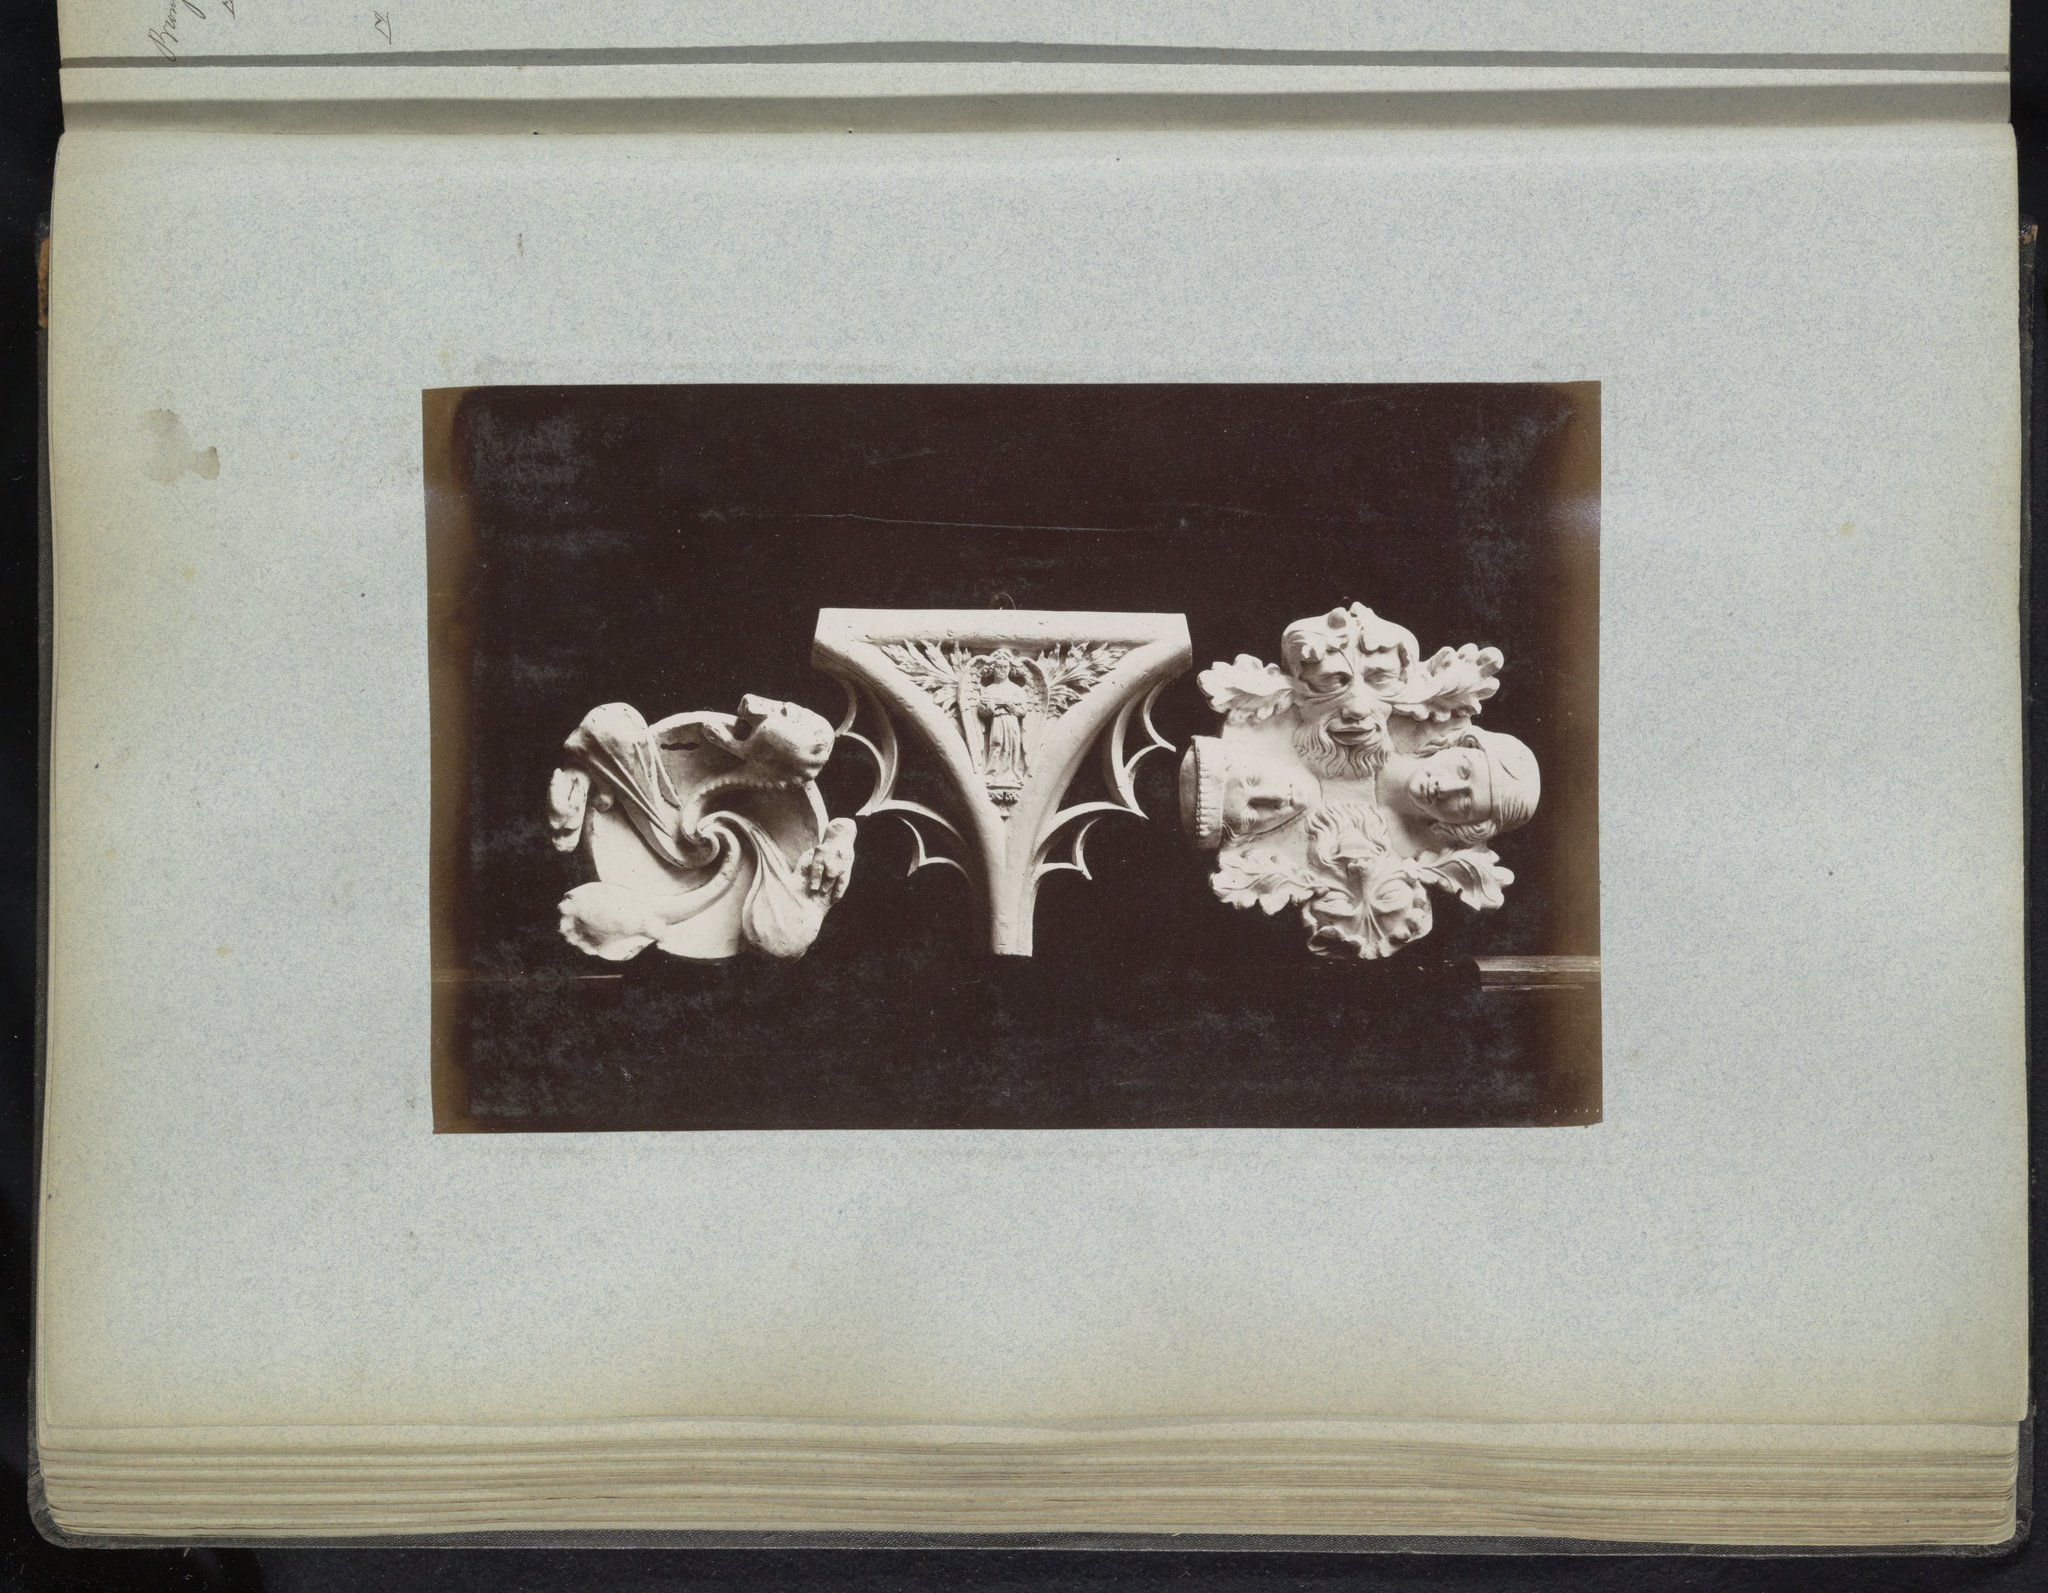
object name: album leaf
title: Drie gipsen afgietsels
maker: Anonymous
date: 1875-1900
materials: paper, photographic support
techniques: albumen print